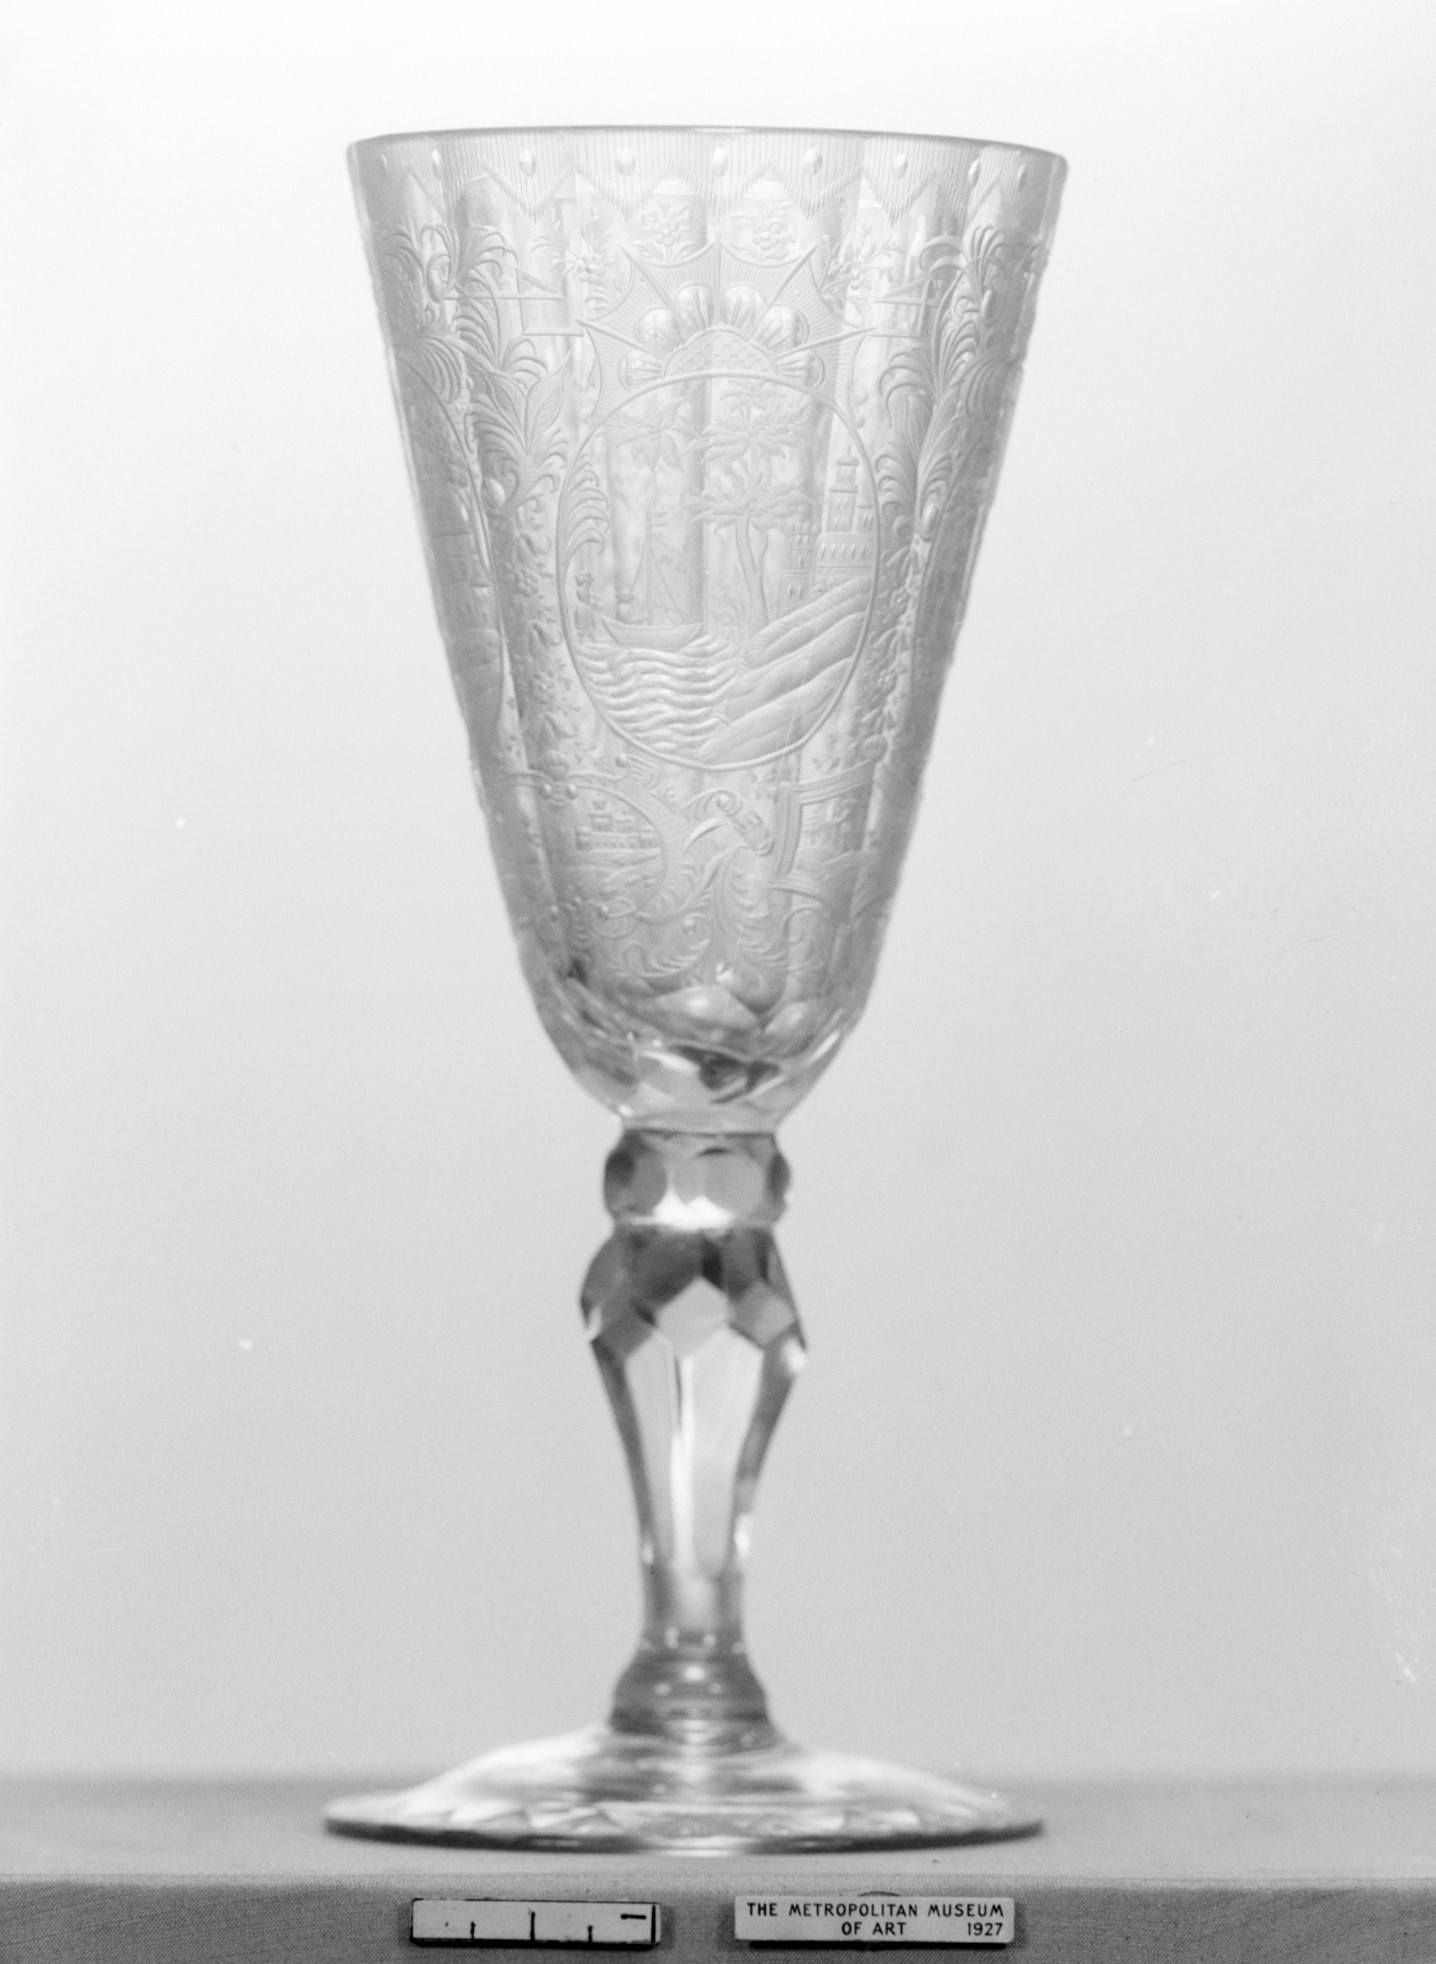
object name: standing cup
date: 1740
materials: glass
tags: trees,boats